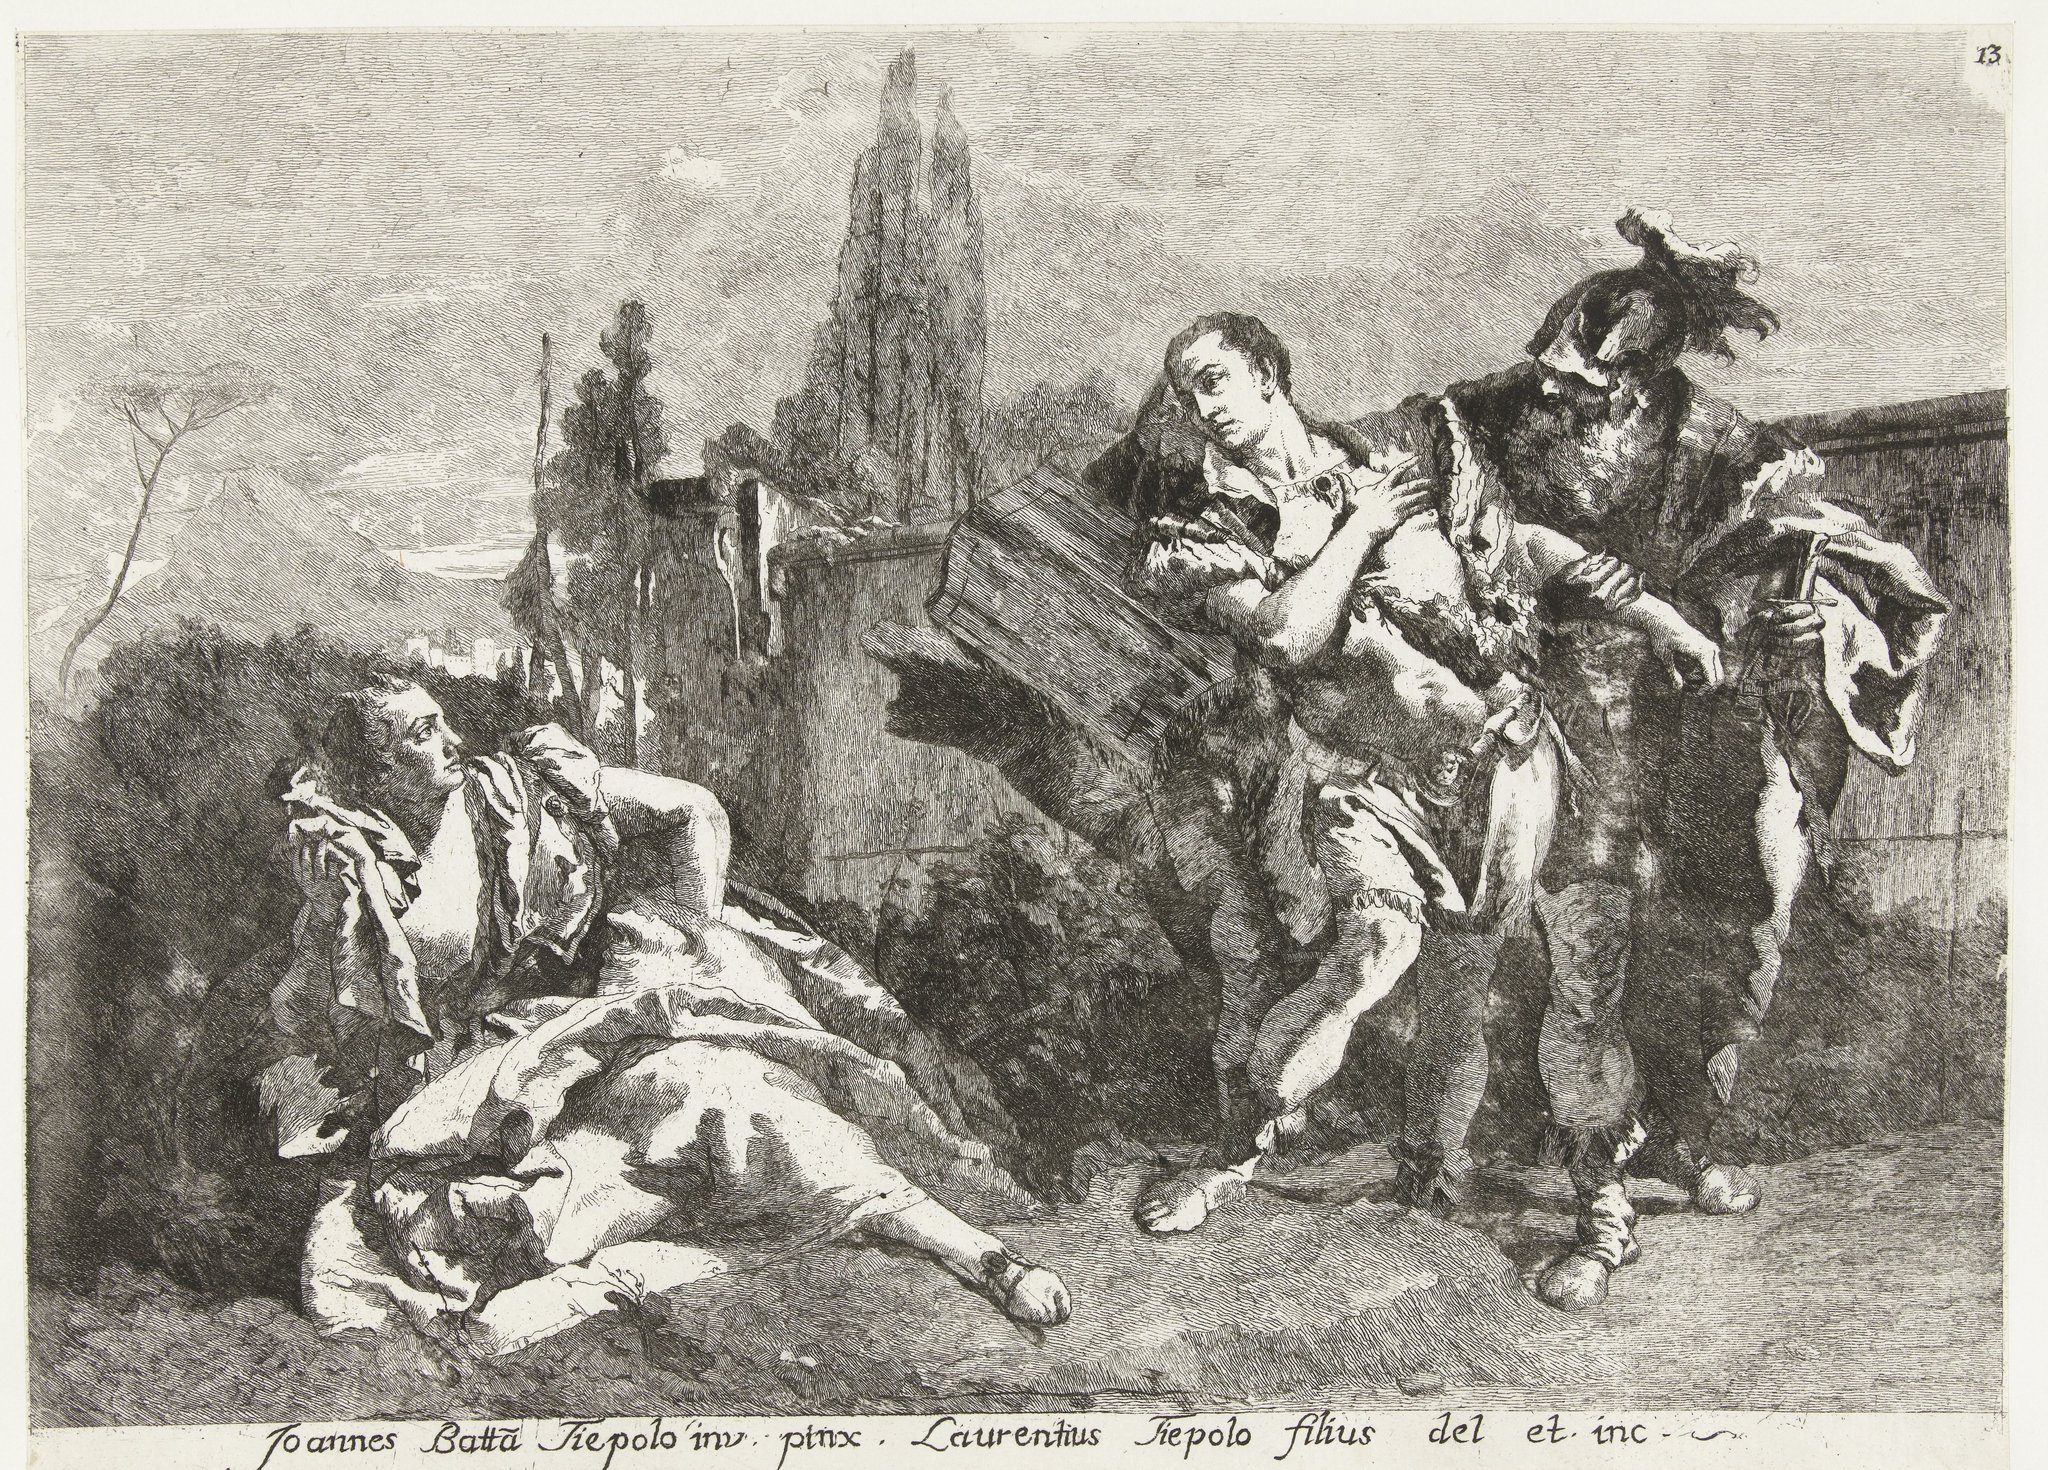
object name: print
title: Rinaldo Abandons Armida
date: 1751-1755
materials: paper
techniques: etching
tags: rinaldo, armida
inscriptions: collector's mark: Lugt 2228, collector's mark: Lugt 2760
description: The scene depicted here is the same as in the adjacent etching by Giovanni Domenico, Rinaldo abandoning Armida. Both brothers based themselves on works by their father: Giovanni Domenico on a fresco in the Villa Valmarana in Vicenza, Lorenzo on a painting in the palace in Würzburg. Giovanni Domenico’s etching technique is somewhat looser and bolder than that of his younger brother.